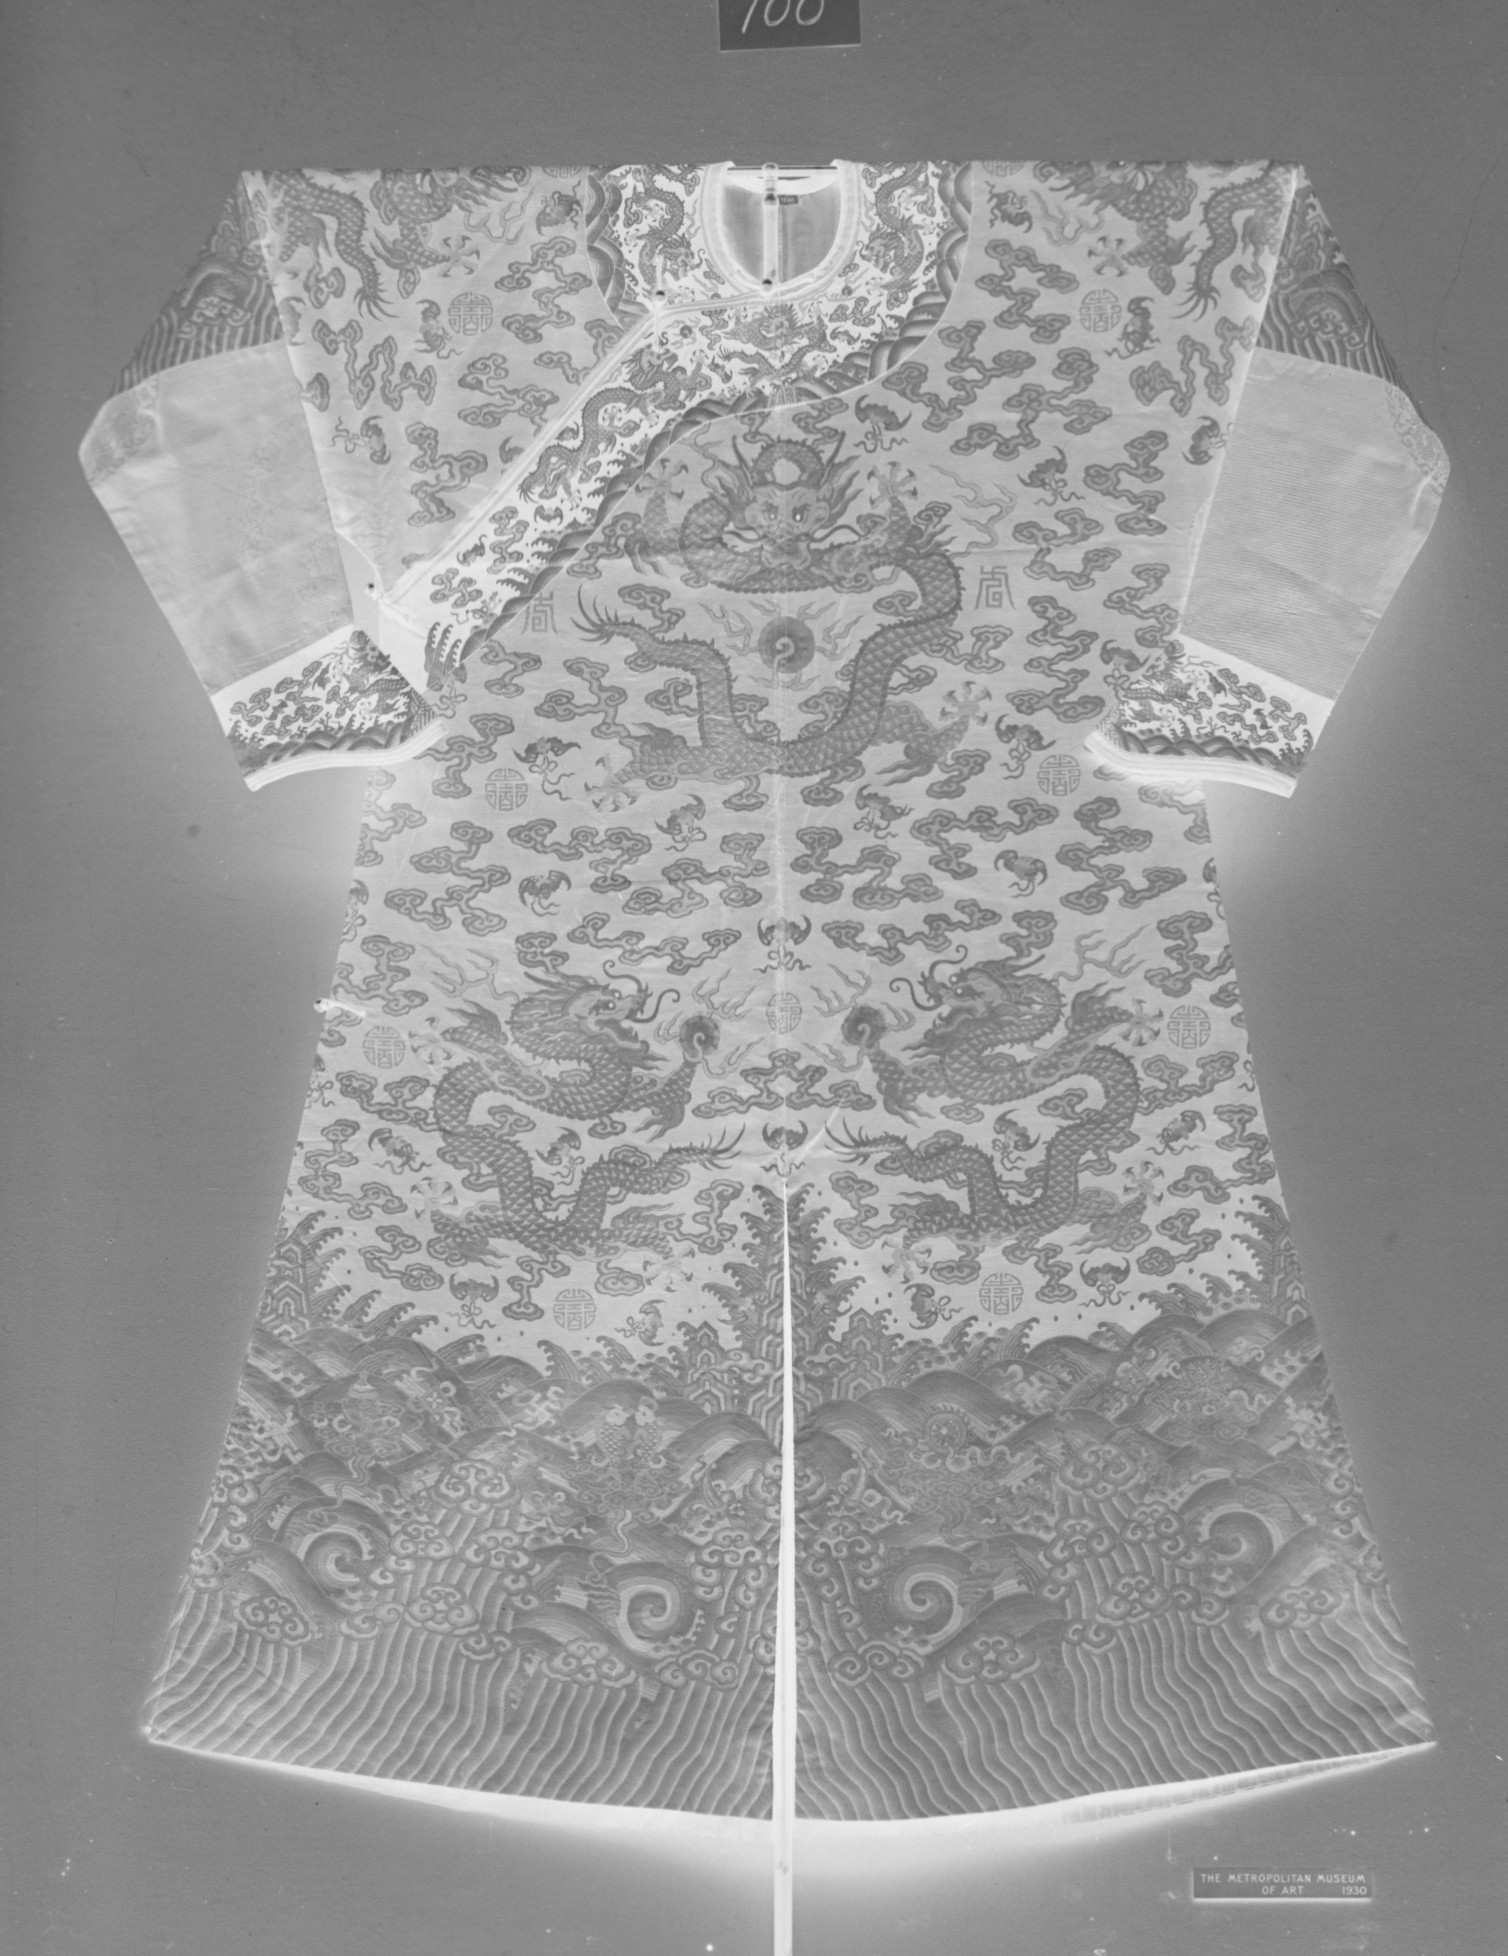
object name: robe, imperial court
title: Imperial Court Robe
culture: chinese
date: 1662-1722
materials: silk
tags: dragons